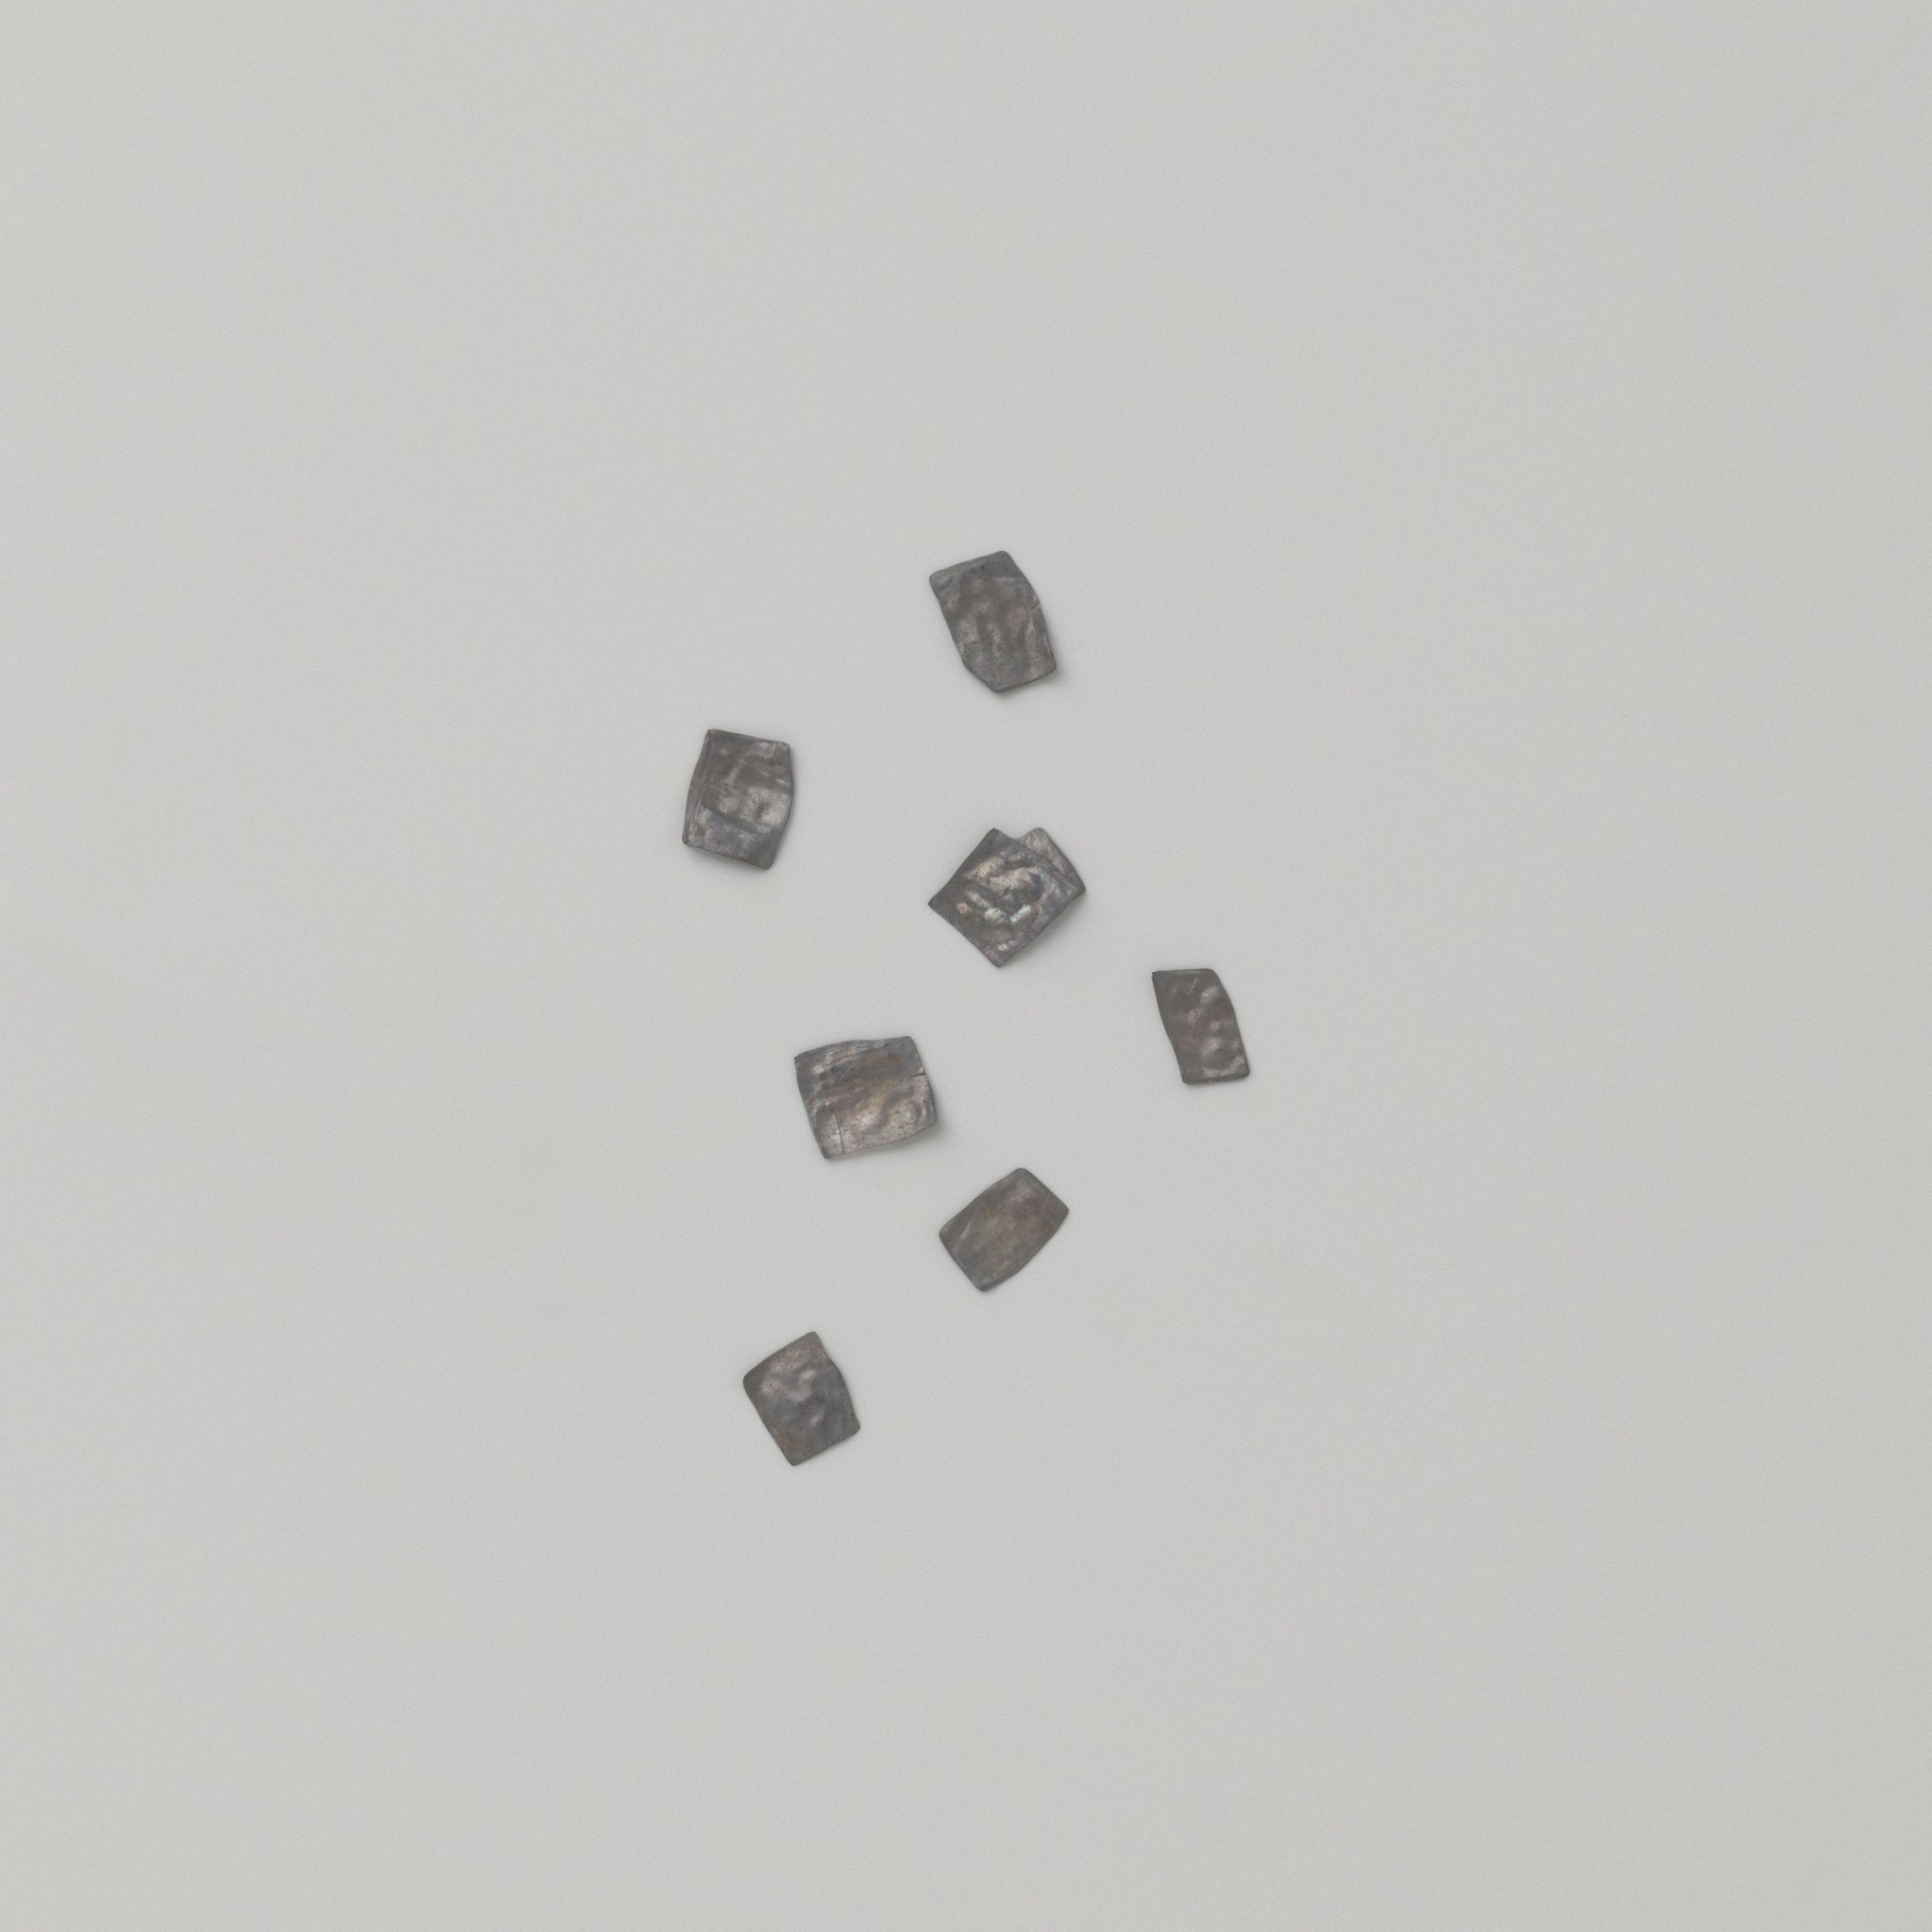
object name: coin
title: Dam [?] uit Nepal, bestaande uit 8 vierkante stukjes bladzilver van gemiddeld 1/100 gram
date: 1700-1900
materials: silver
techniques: striking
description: Acht zilveren vierkante stukjes bladzilver, waarvan sommige met letters bestempeld, gebruikt als munt.